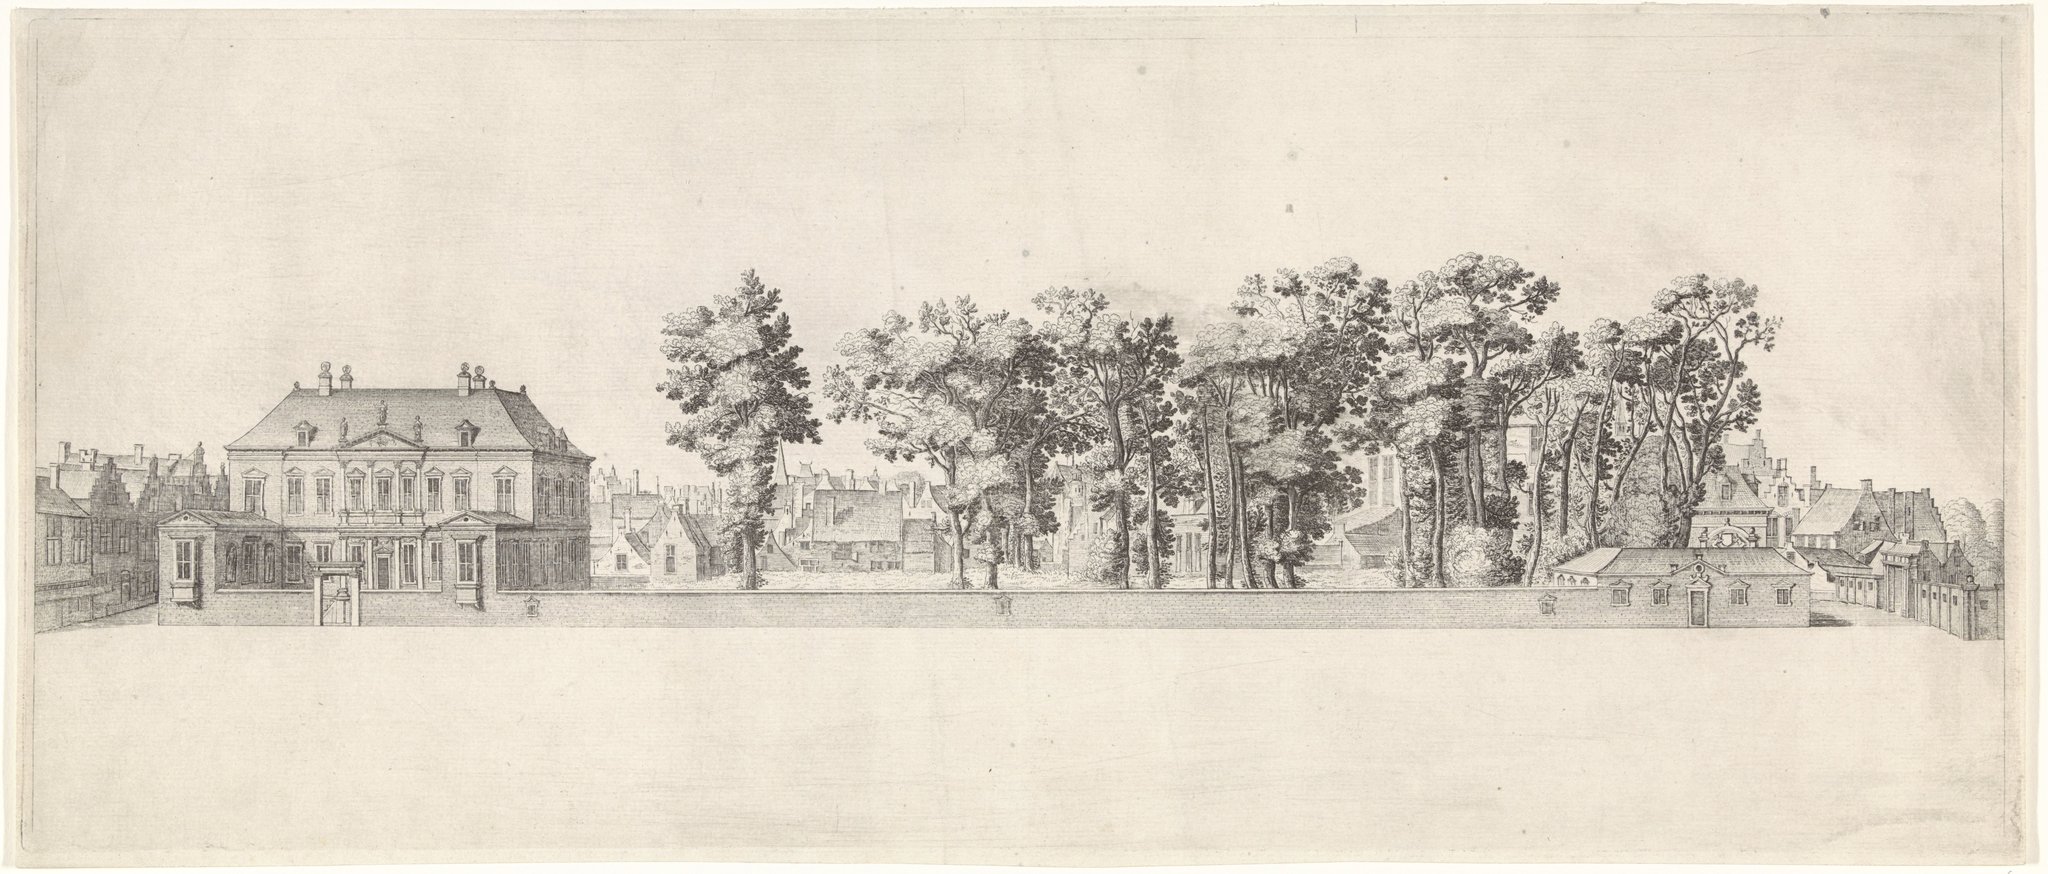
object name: print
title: Gezicht op het huis van Huygens aan het Plein te Den Haag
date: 1639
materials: paper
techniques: engraving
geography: northern netherlands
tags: the hague, constantijn huygens (i), urban housing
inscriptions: collector's mark: Lugt 2228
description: Gezicht op het Plein in Den Haag met links het huis van Constantijn Huygens.